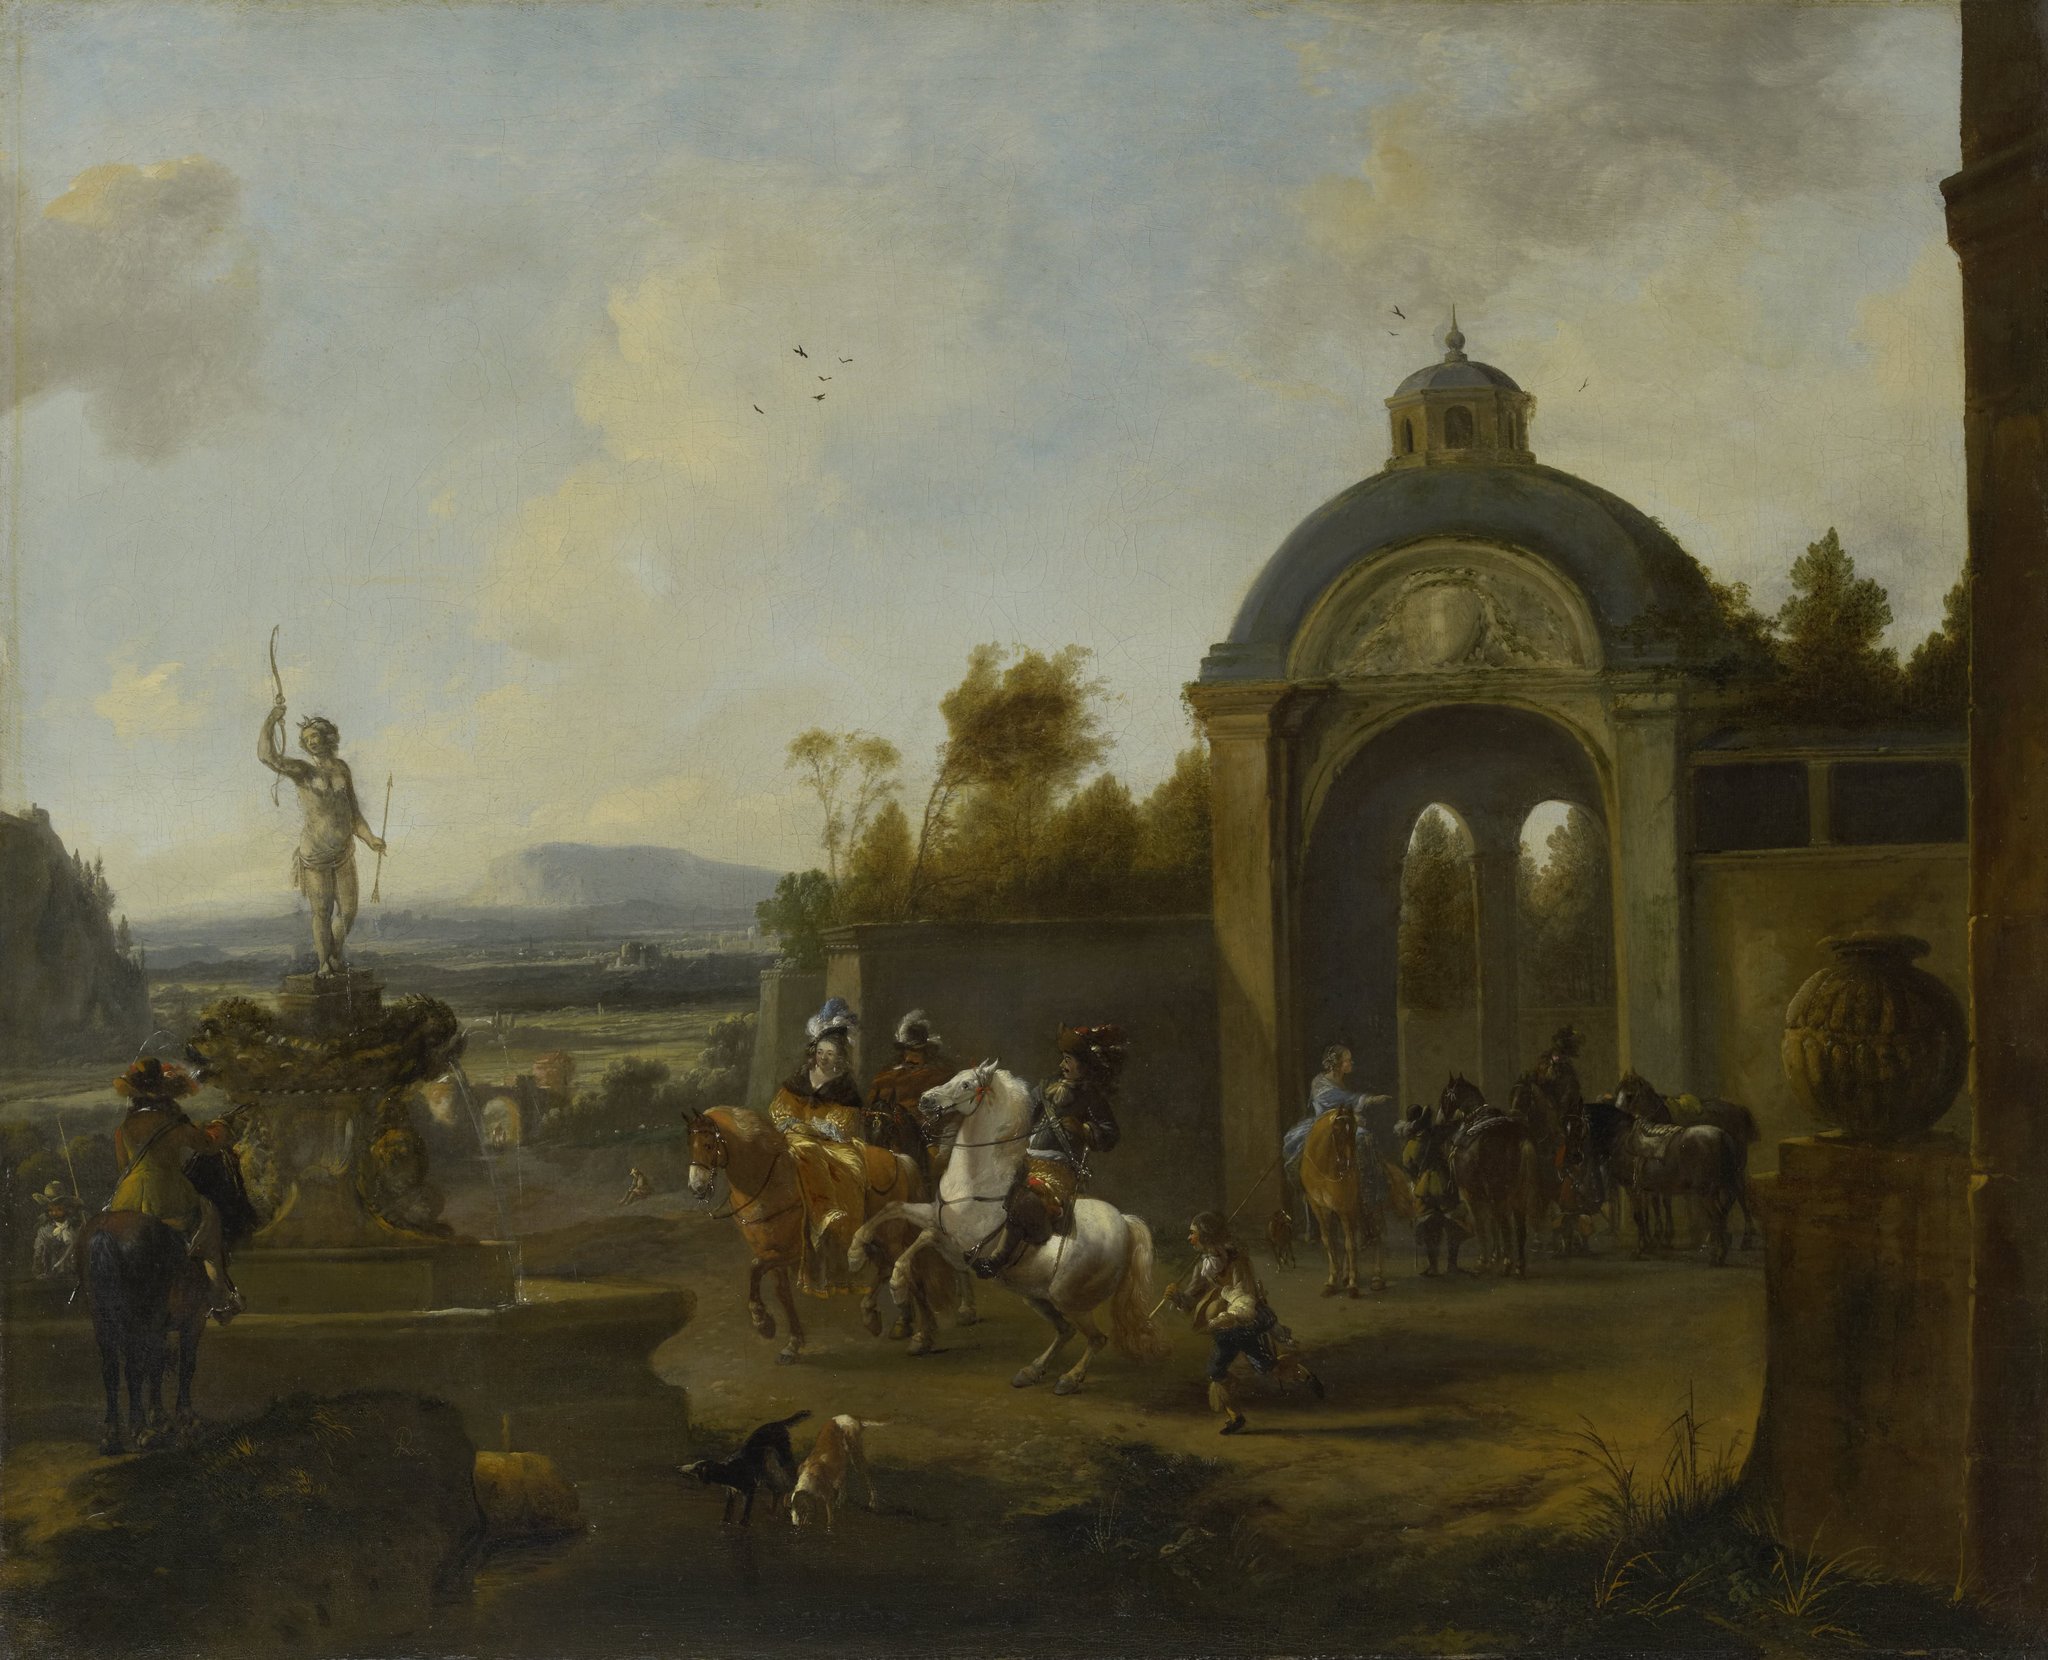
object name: painting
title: Hunting Party at a Fountain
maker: pieter wouwerman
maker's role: painter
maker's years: 1623-1682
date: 1660-1682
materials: canvas, oil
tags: ornamental fountain, assembling, 'départ pour la chasse', utilitarian, public pump or water fountain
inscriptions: signature: ‘P.W.’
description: Jachtgezelschap bij een fontein. Een jachtpartij van dames en heren te paard, knechten en honden verzamelt zich bij een fontein met een beeld van Diana bij de poort van een buitenhuis.